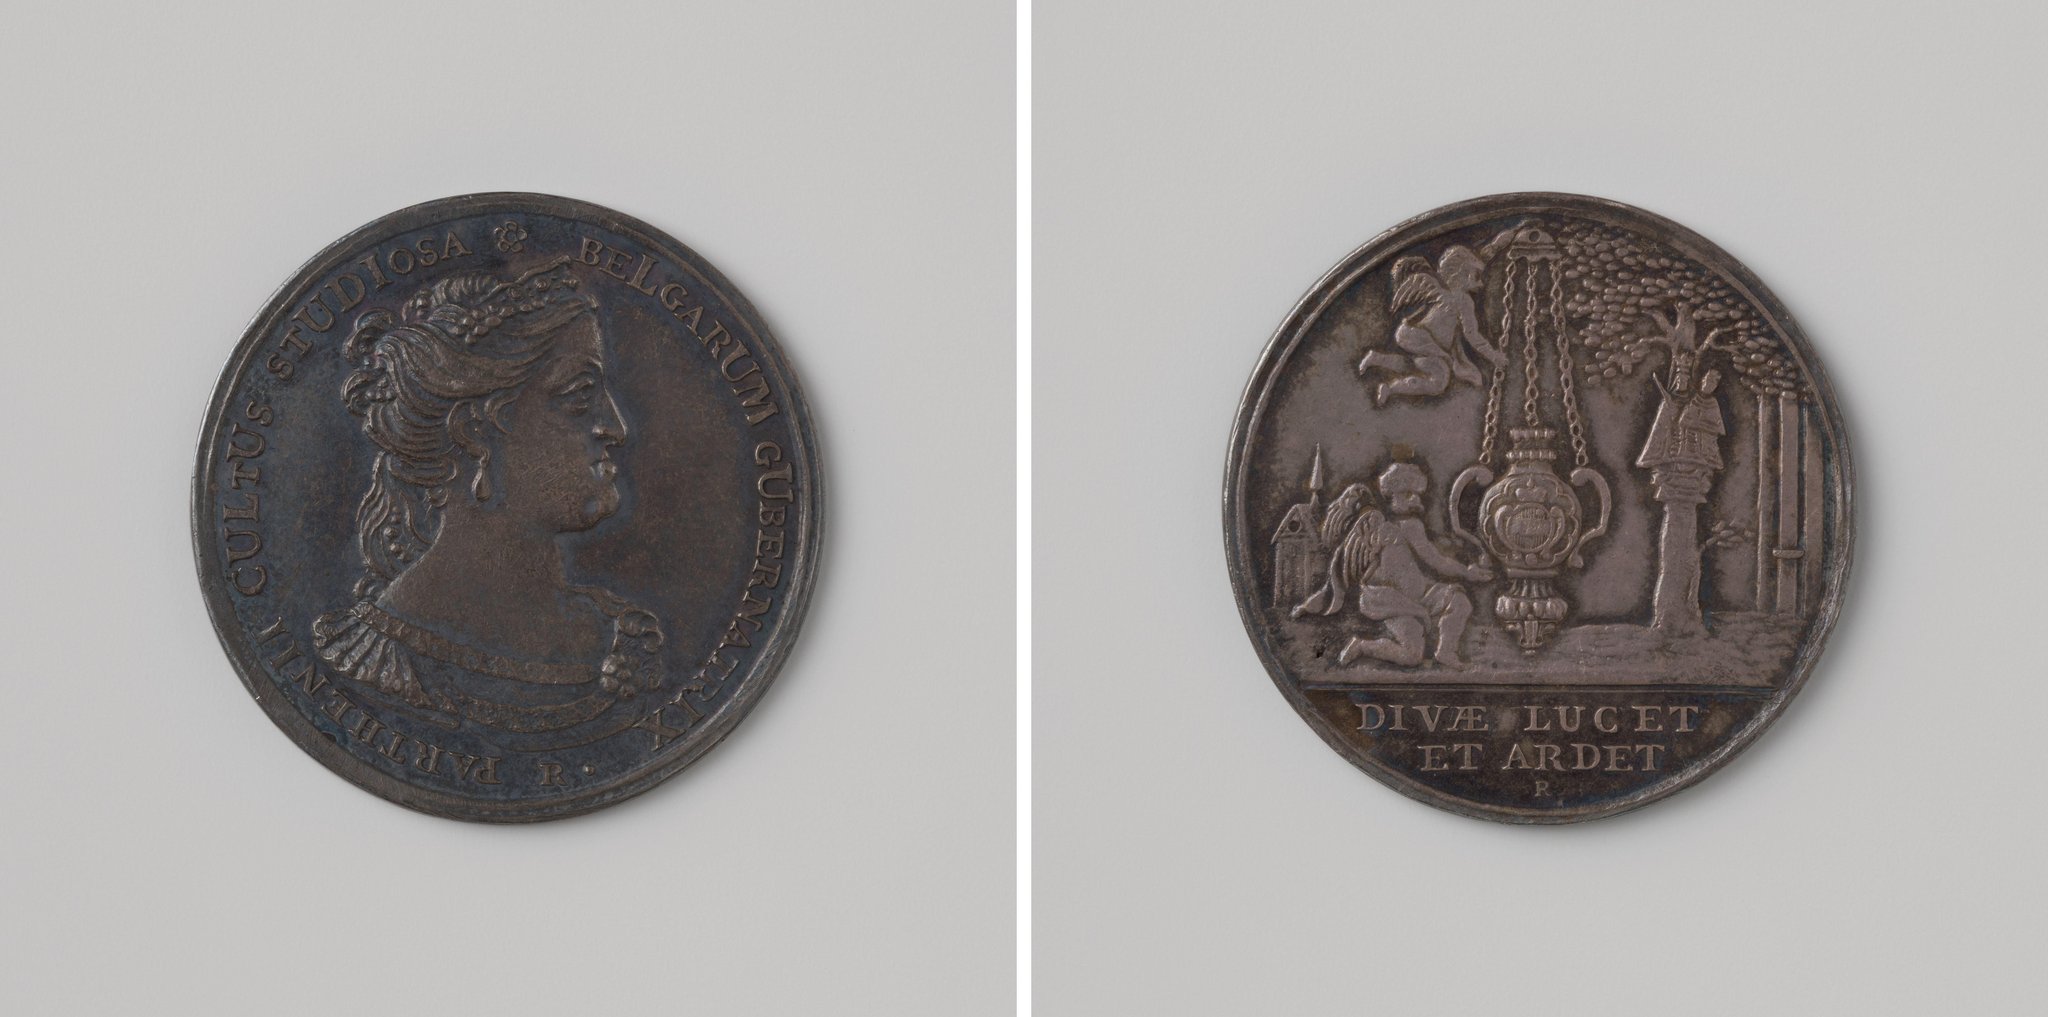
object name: new year medal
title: Pelgrimstocht van Maria Elisabeth, landvoogdes der zuidelijke Nederlanden naar Montaigu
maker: jacques roëttiers (ii)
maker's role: medailleur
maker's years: 1698-1772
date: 1739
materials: silver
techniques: striking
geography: antwerp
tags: scherpenheuvel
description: Zilveren penning. Voorzijde: borststuk vrouw met diadeem binnen omschrift. Keerzijde: lamp versierd met wapenschild wordt door twee engeltjes vastgehouden, rechts een boom waartegen een mariabeeld staat, links de Notre-Dame van Montaigu; afsnede: opschrift.